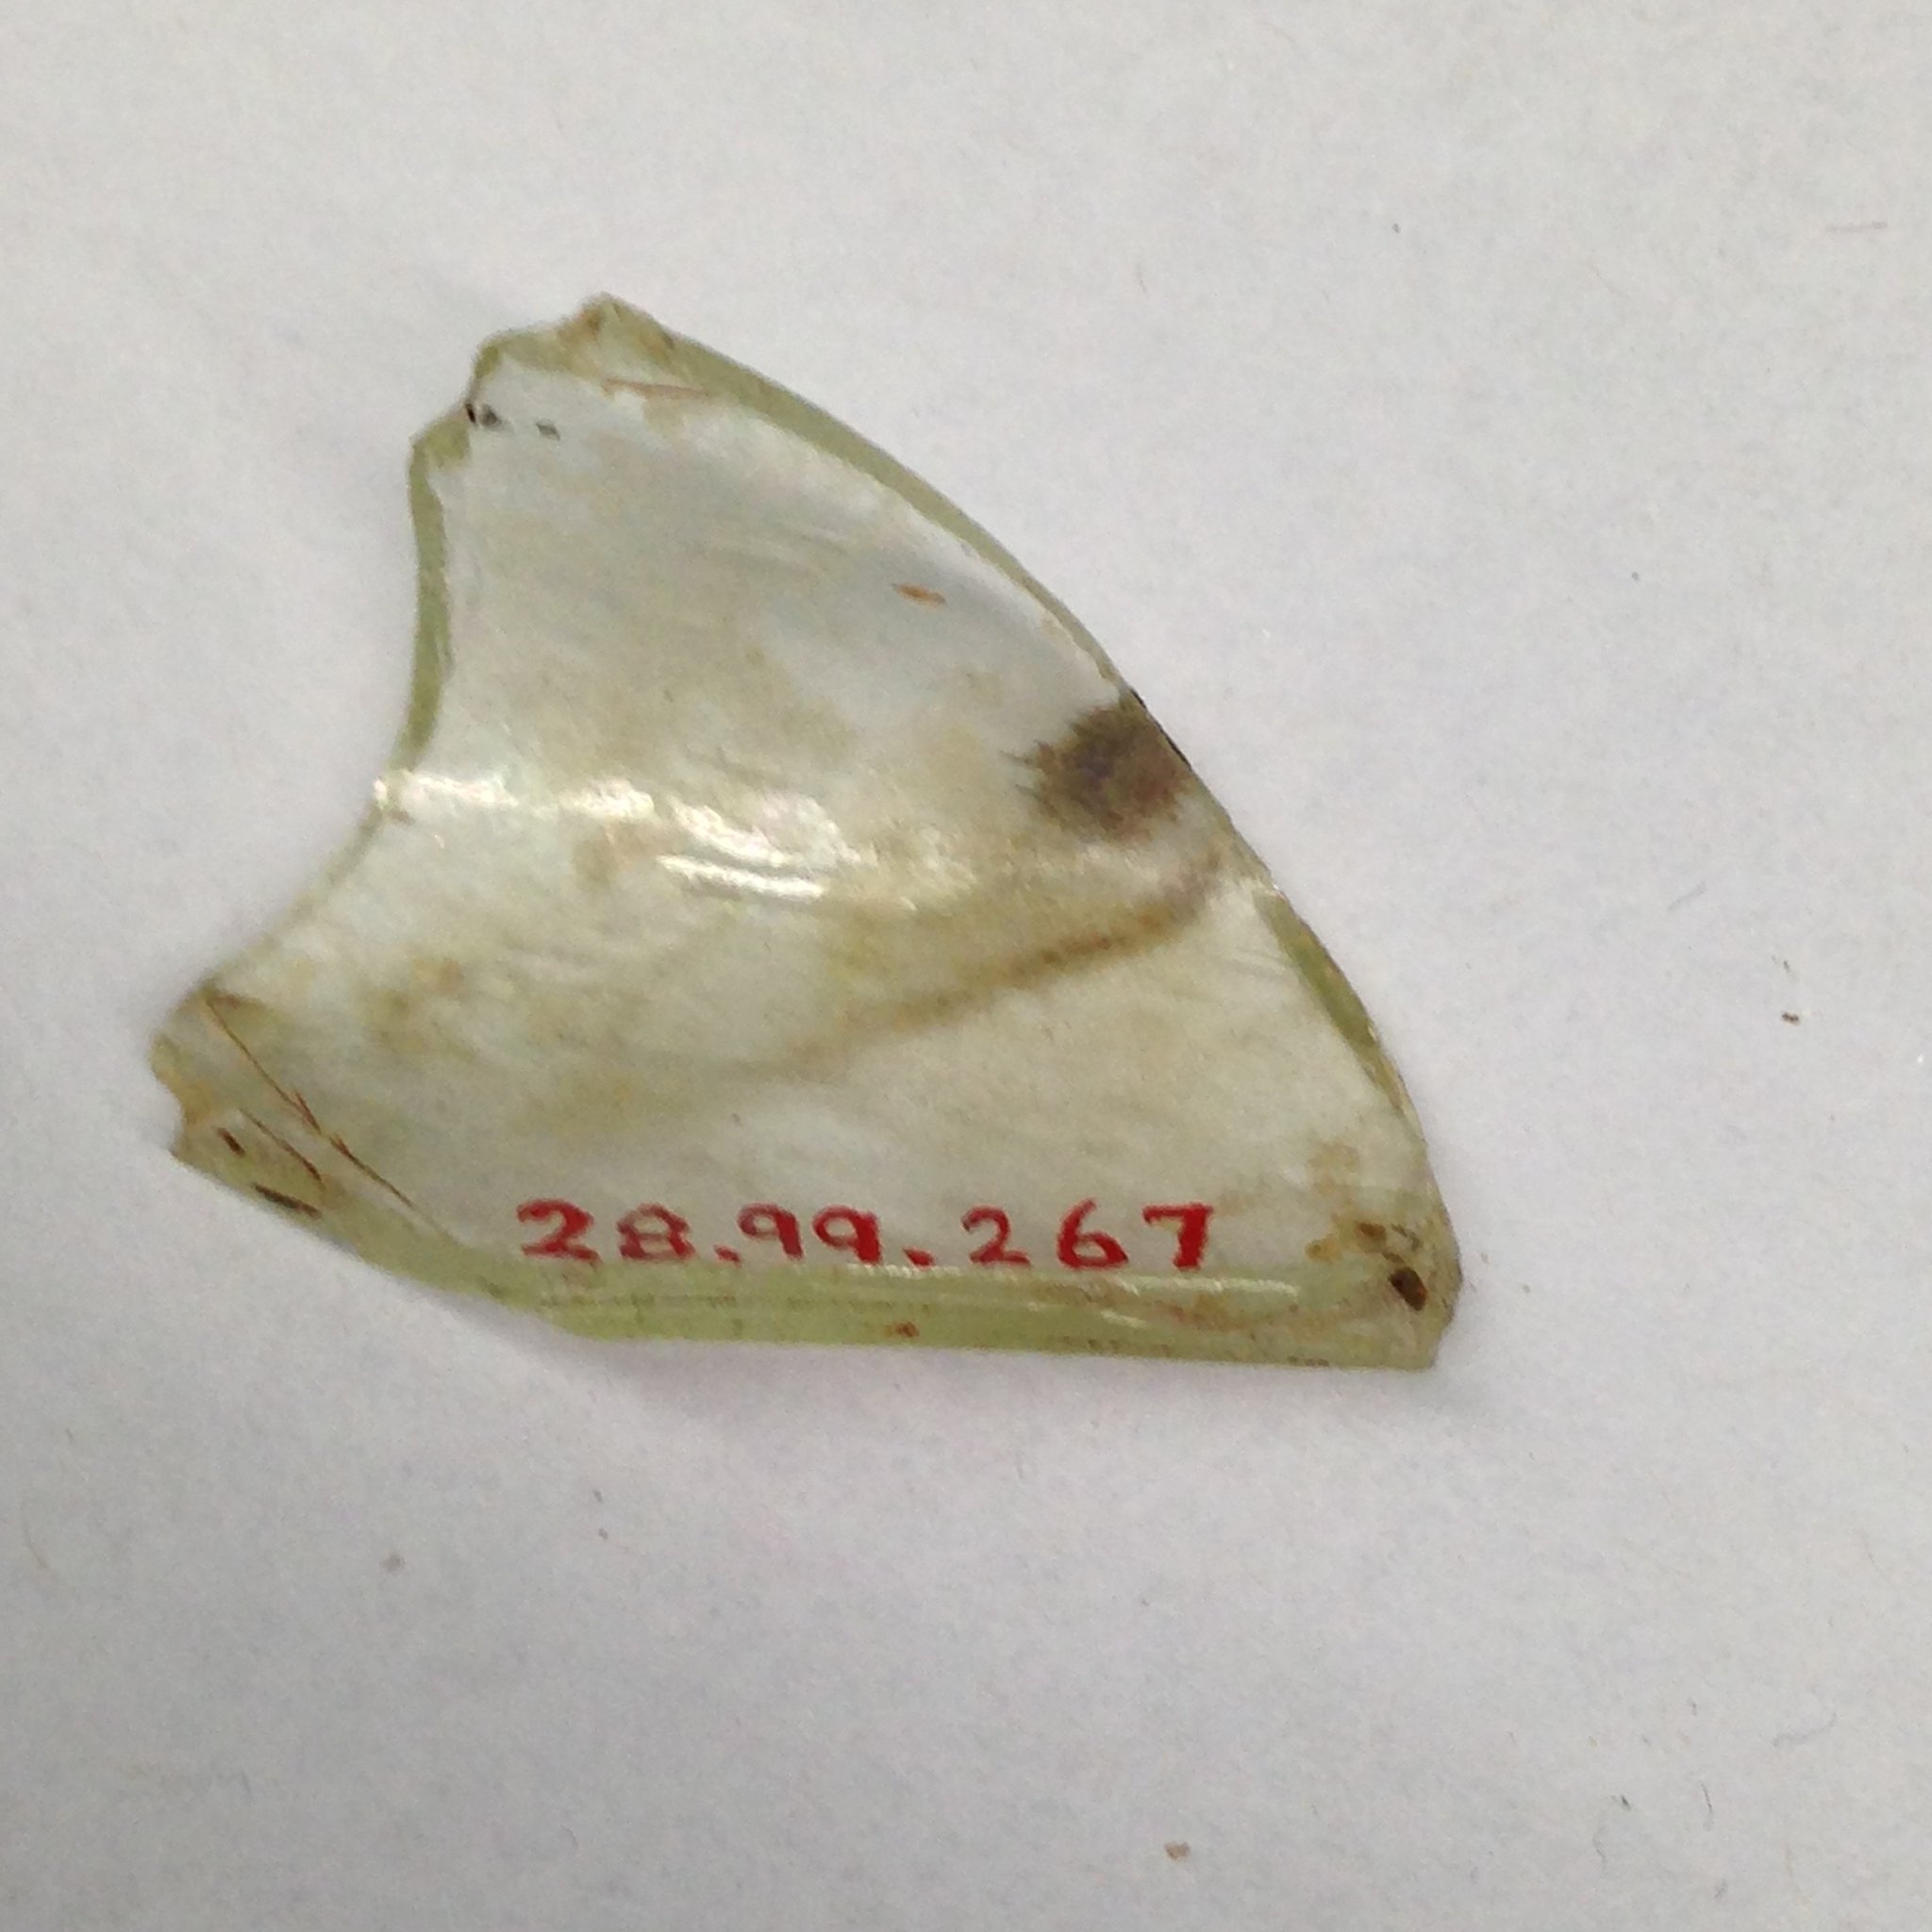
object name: fragment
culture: european or middle eastern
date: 1150-1250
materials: ceramic, glass